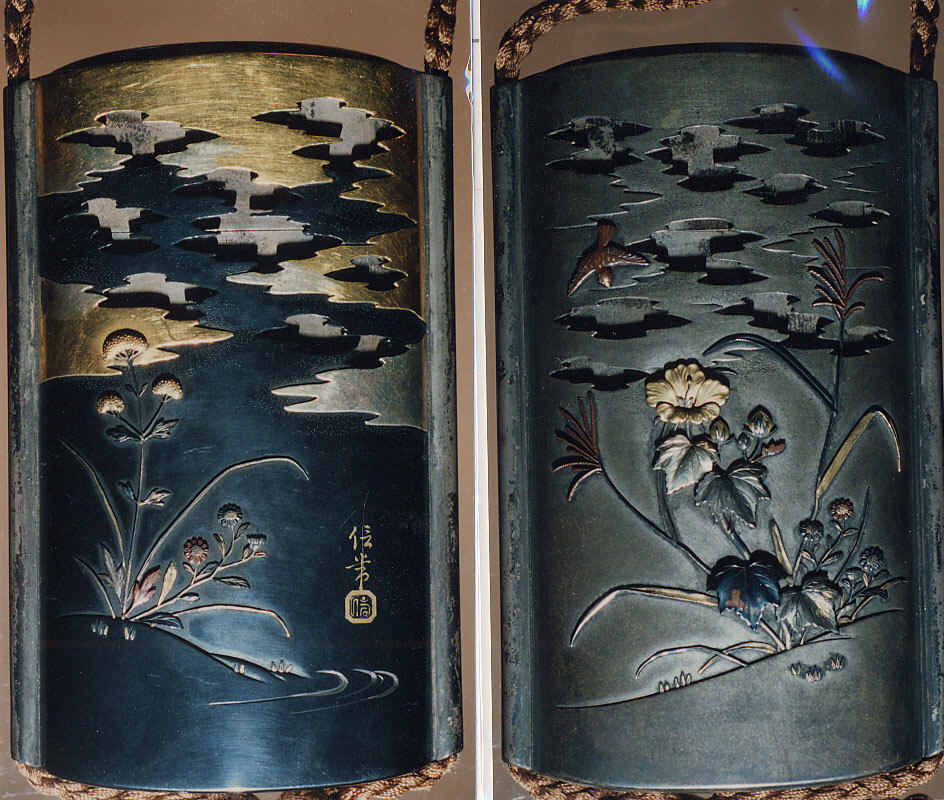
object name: inrō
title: Case (Inrō) with Design of Hibiscus and Autumn Flowers beneath Clouds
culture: japanese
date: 1801-1900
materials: gold, metal, silver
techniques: relief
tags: flowers,clouds